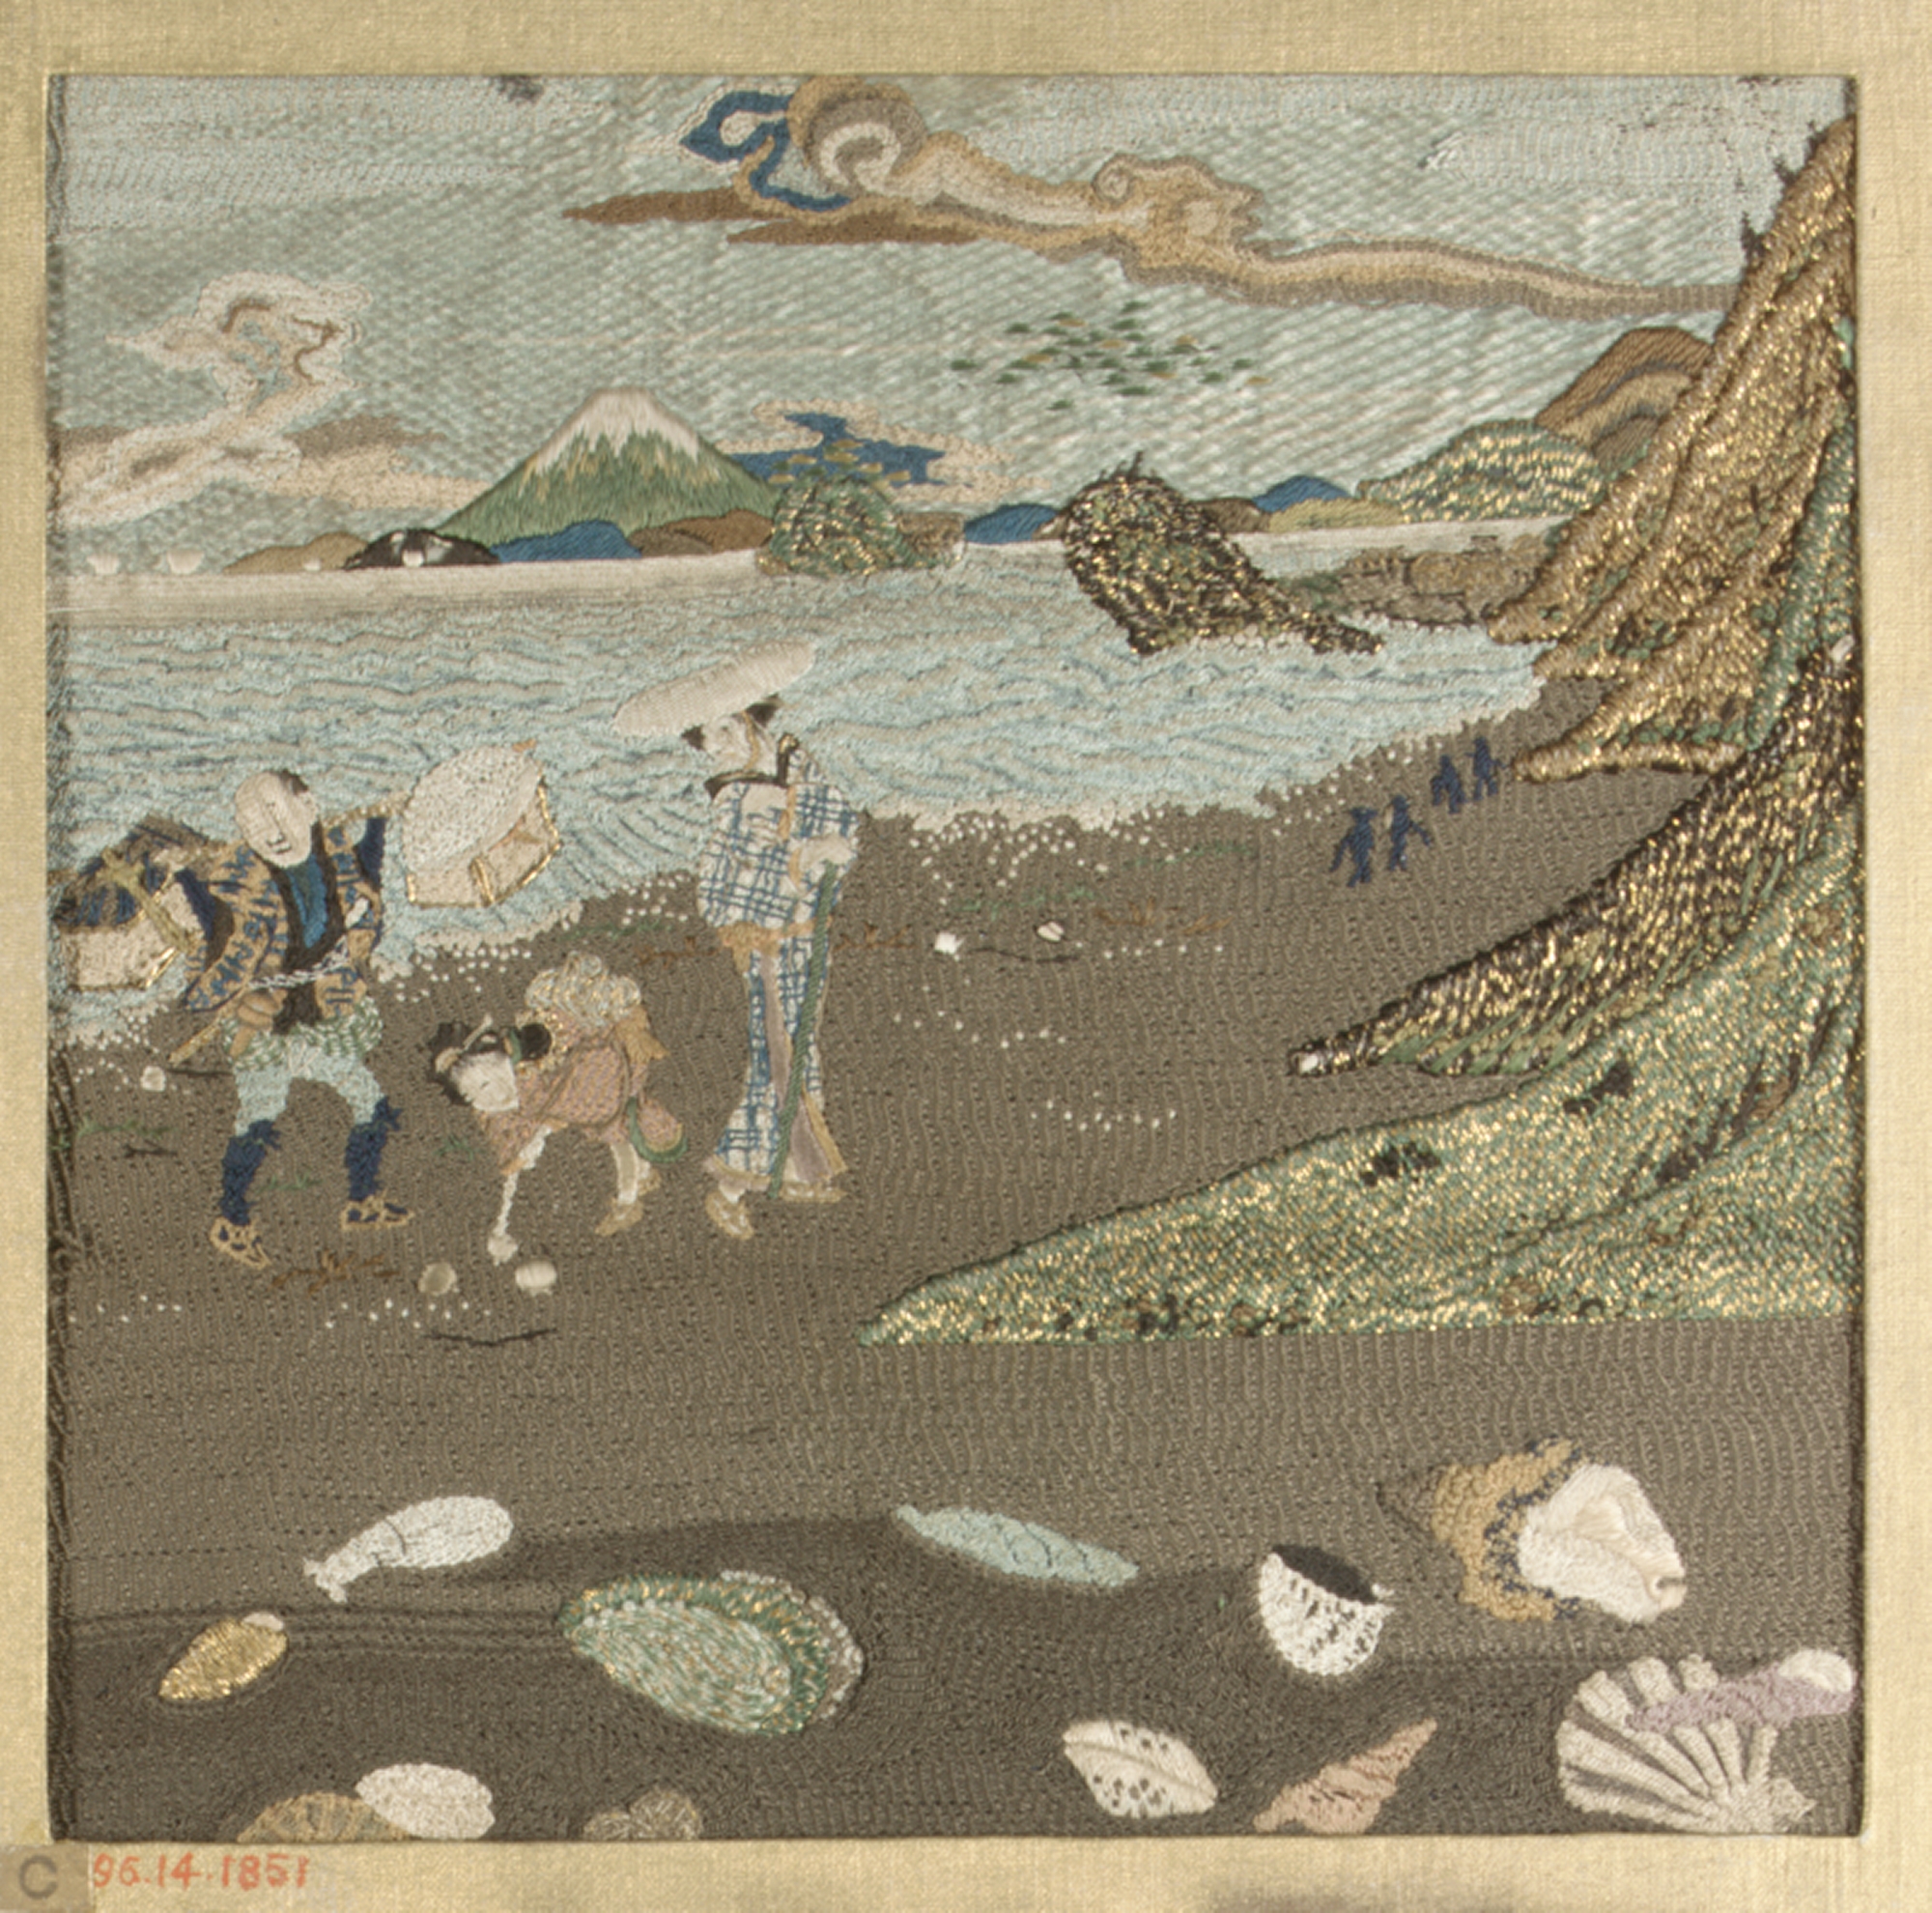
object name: piece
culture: japanese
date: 1701-1900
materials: silk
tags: human figures,mountains,seascapes